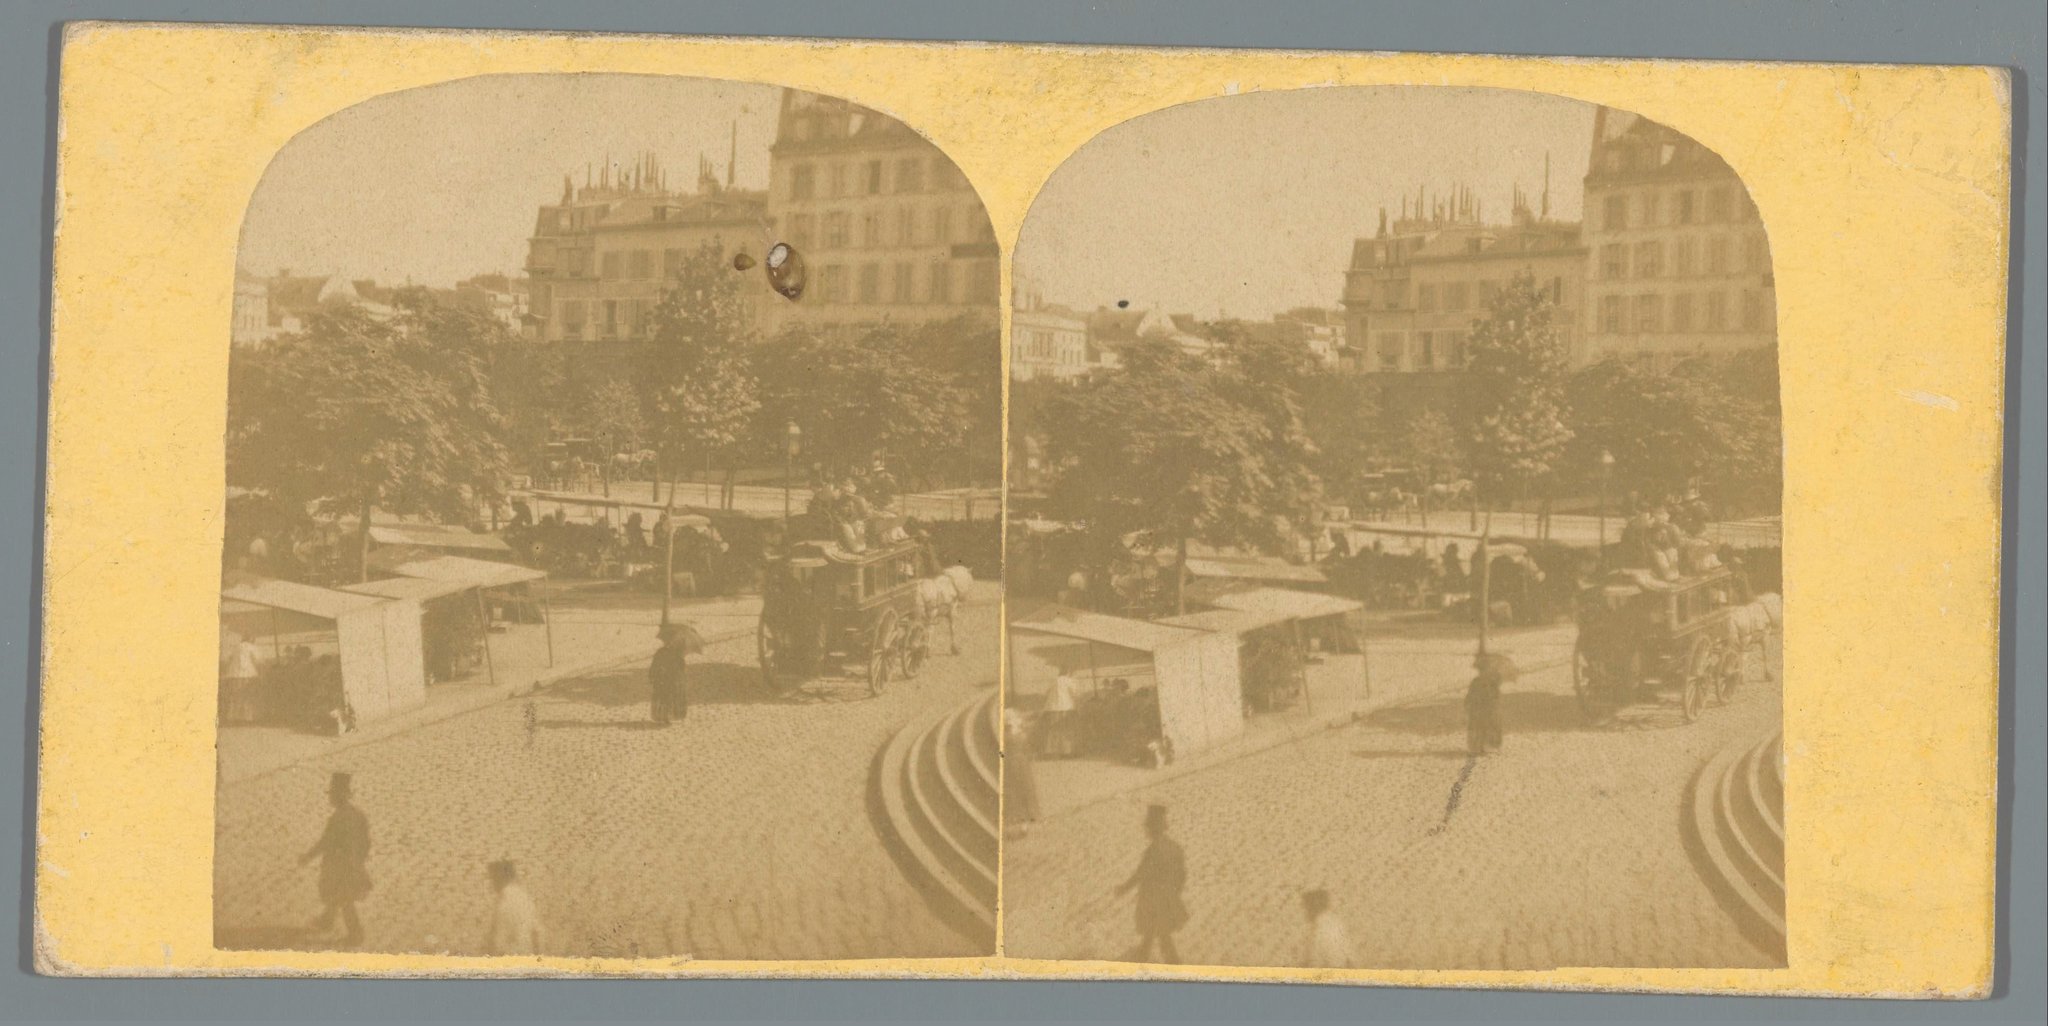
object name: stereograph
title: Gezicht op een bloemenmarkt op de Boulevard du Temple in Parijs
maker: Anonymous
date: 1850-1880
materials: cardboard, photographic support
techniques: albumen print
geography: paris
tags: four-wheeled, animal-drawn vehicle, e.g.: cab, carriage, coach, market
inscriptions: inscription: ‘Marche aux fleurs du Boulevard du Temple, Paris’, number: ‘49’